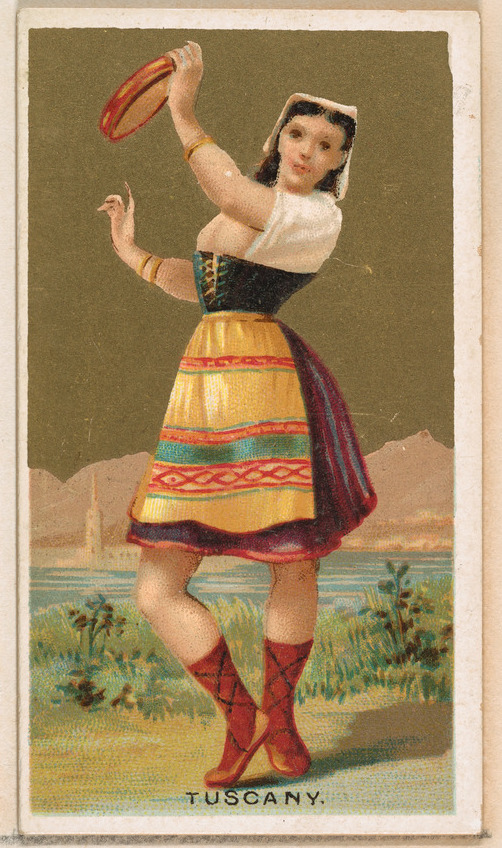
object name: print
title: Tuscany, from the Dancing Girls of the World series (N185) issued by Wm. S. Kimball & Co.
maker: william s. kimball & company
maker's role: publisher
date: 1889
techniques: color lithograph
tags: women,dancing,dancers